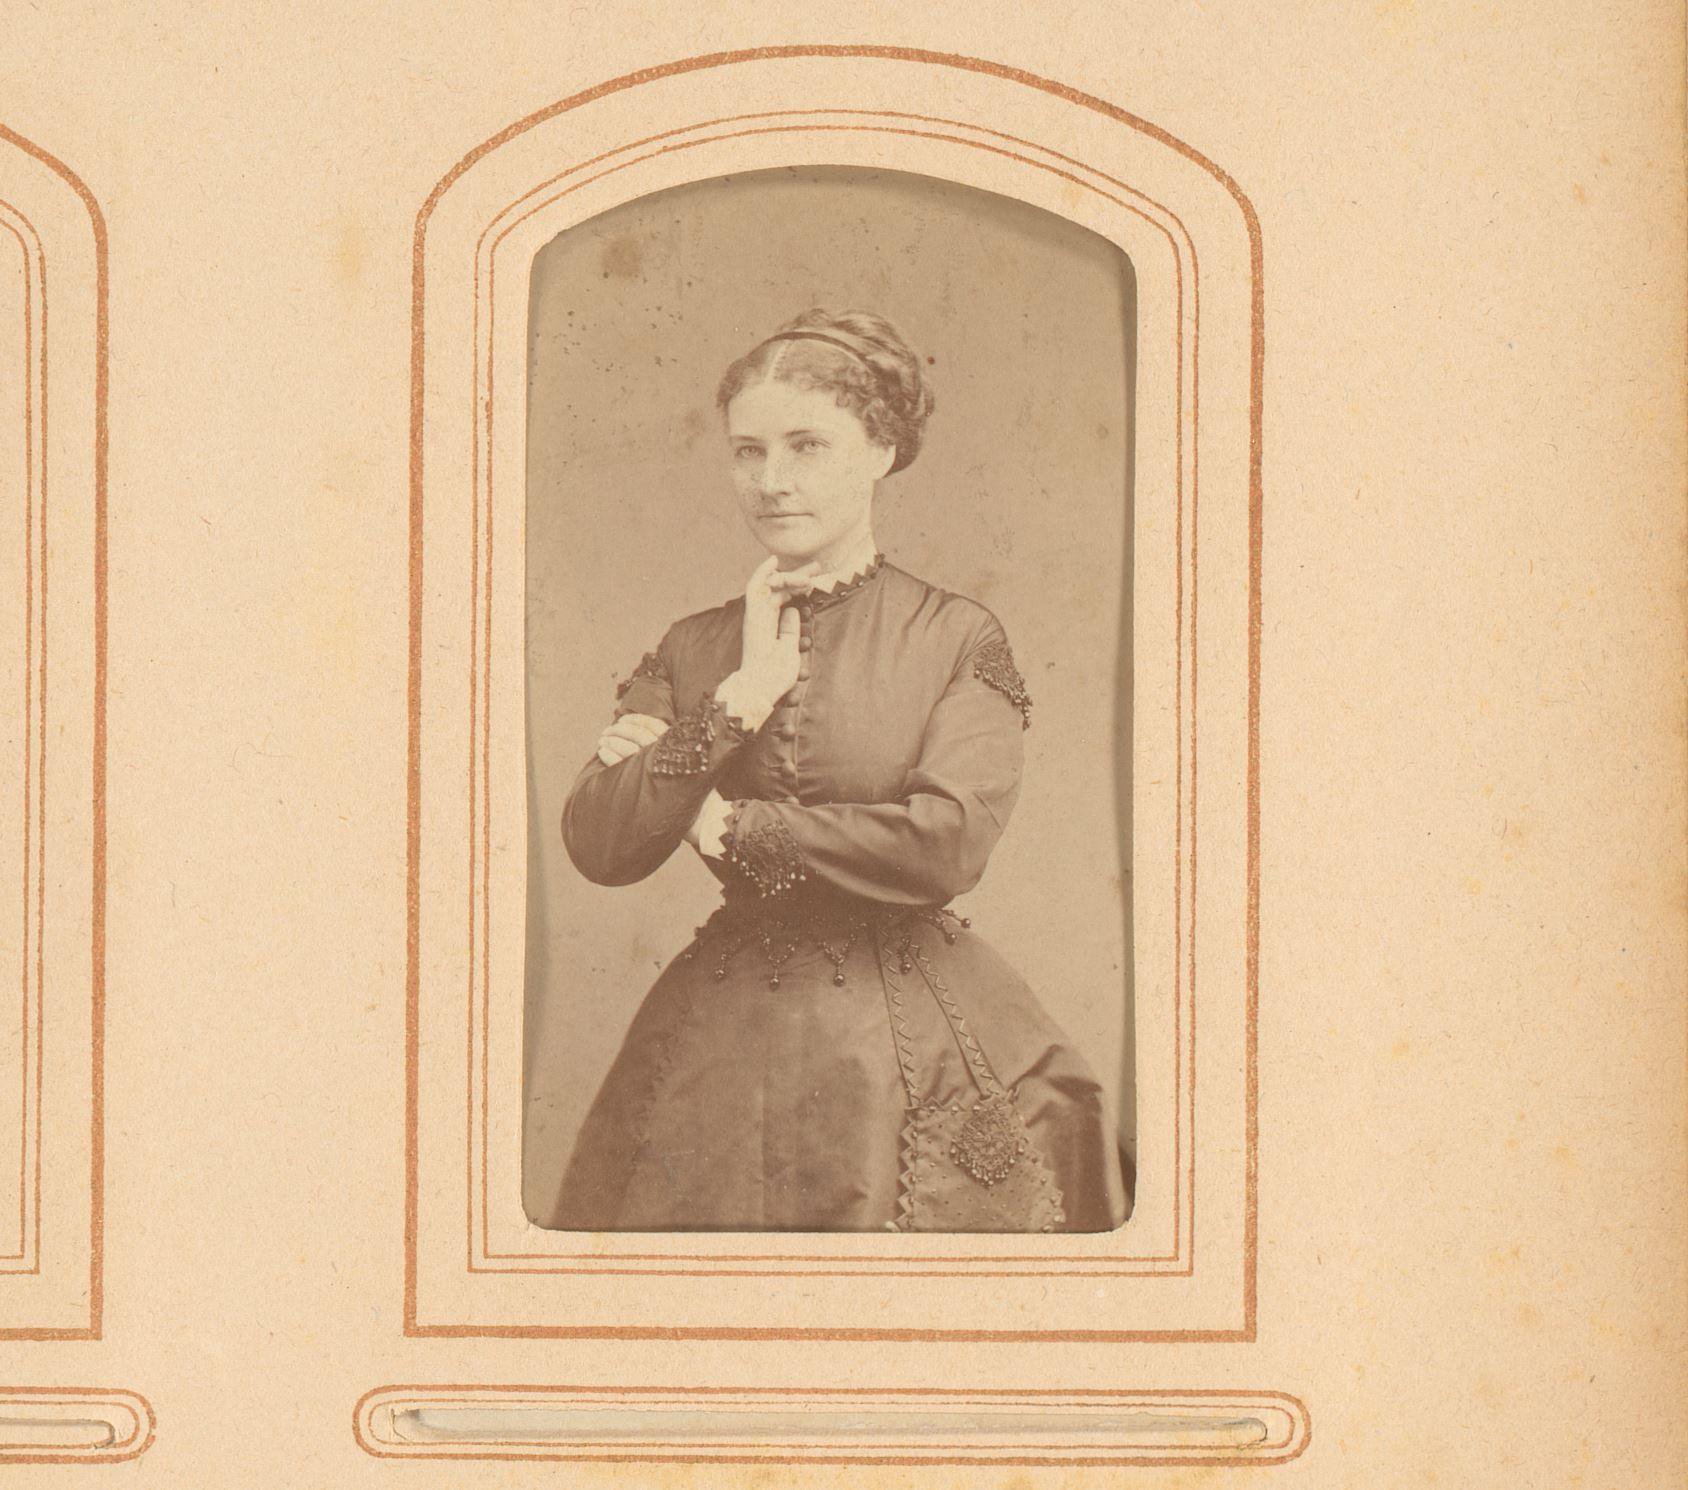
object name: album leaf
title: Portret van Elise Hwasser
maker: matheus hansen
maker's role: fotograaf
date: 1850-1890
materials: cardboard, photographic support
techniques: albumen print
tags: historical persons, portrait of actor, actress, standing figure - aa - female human figure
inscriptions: annotation: ‘Elise Hwasser/ [...] Jacobsson/ 1831-1894’, inscription: ‘Maths Hansen/ Kongl Hof Photograf/ Regeringsgatan No. 11/ Stockholm’